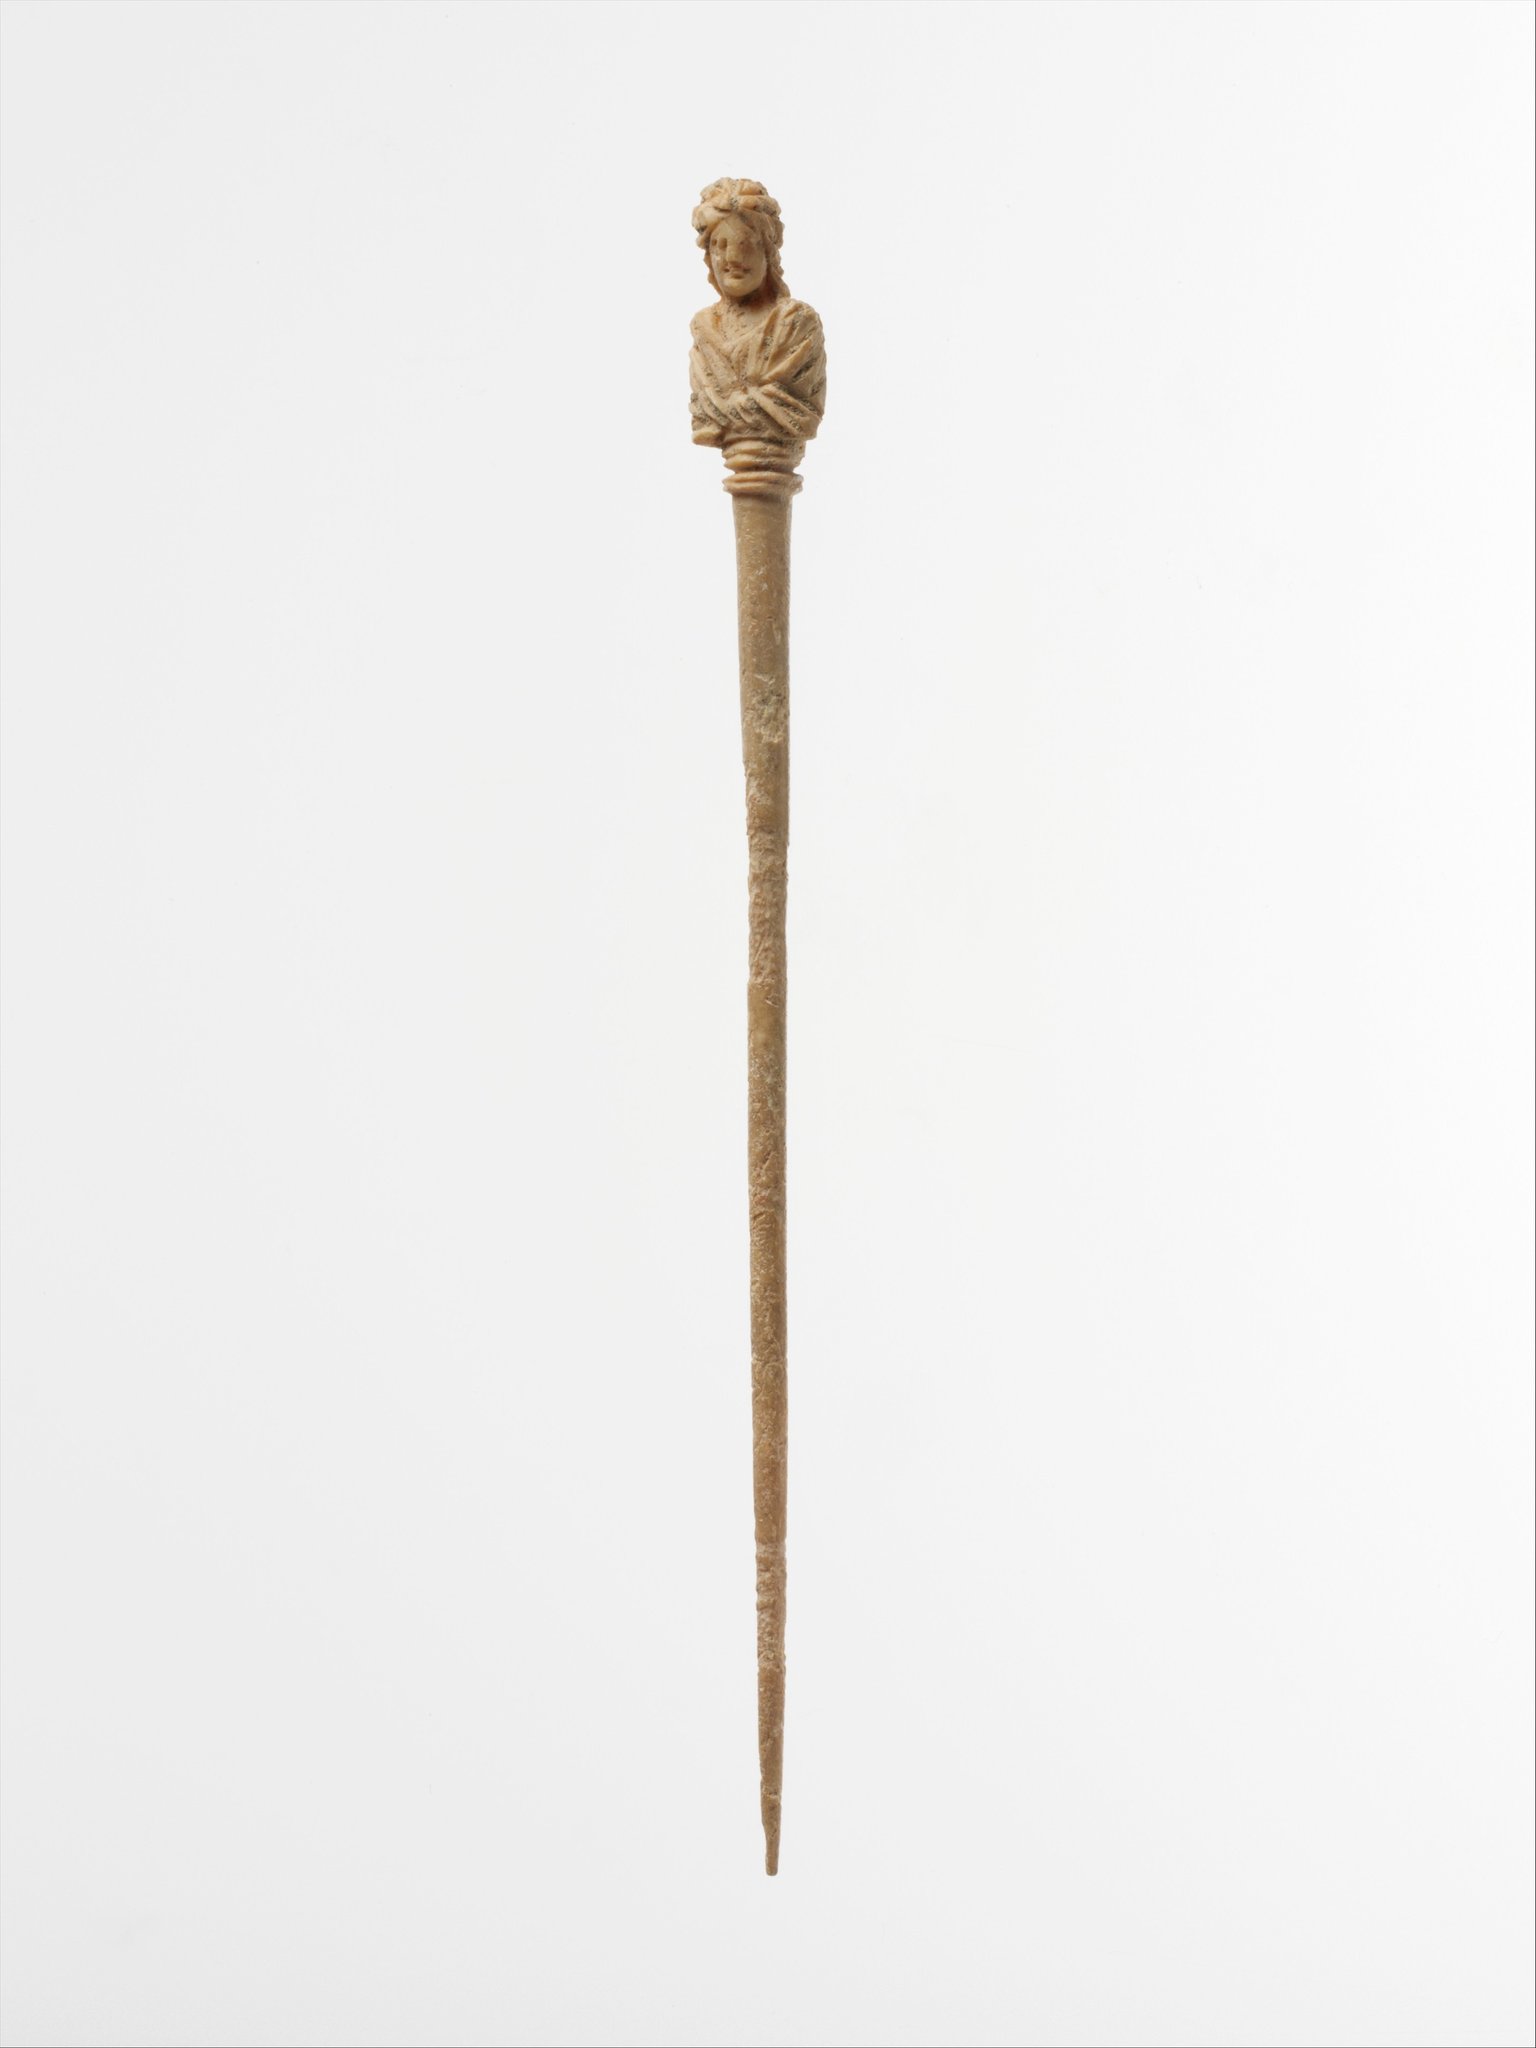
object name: pin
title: Bone hairpin with bust of a woman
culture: roman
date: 101-300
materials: bone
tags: women